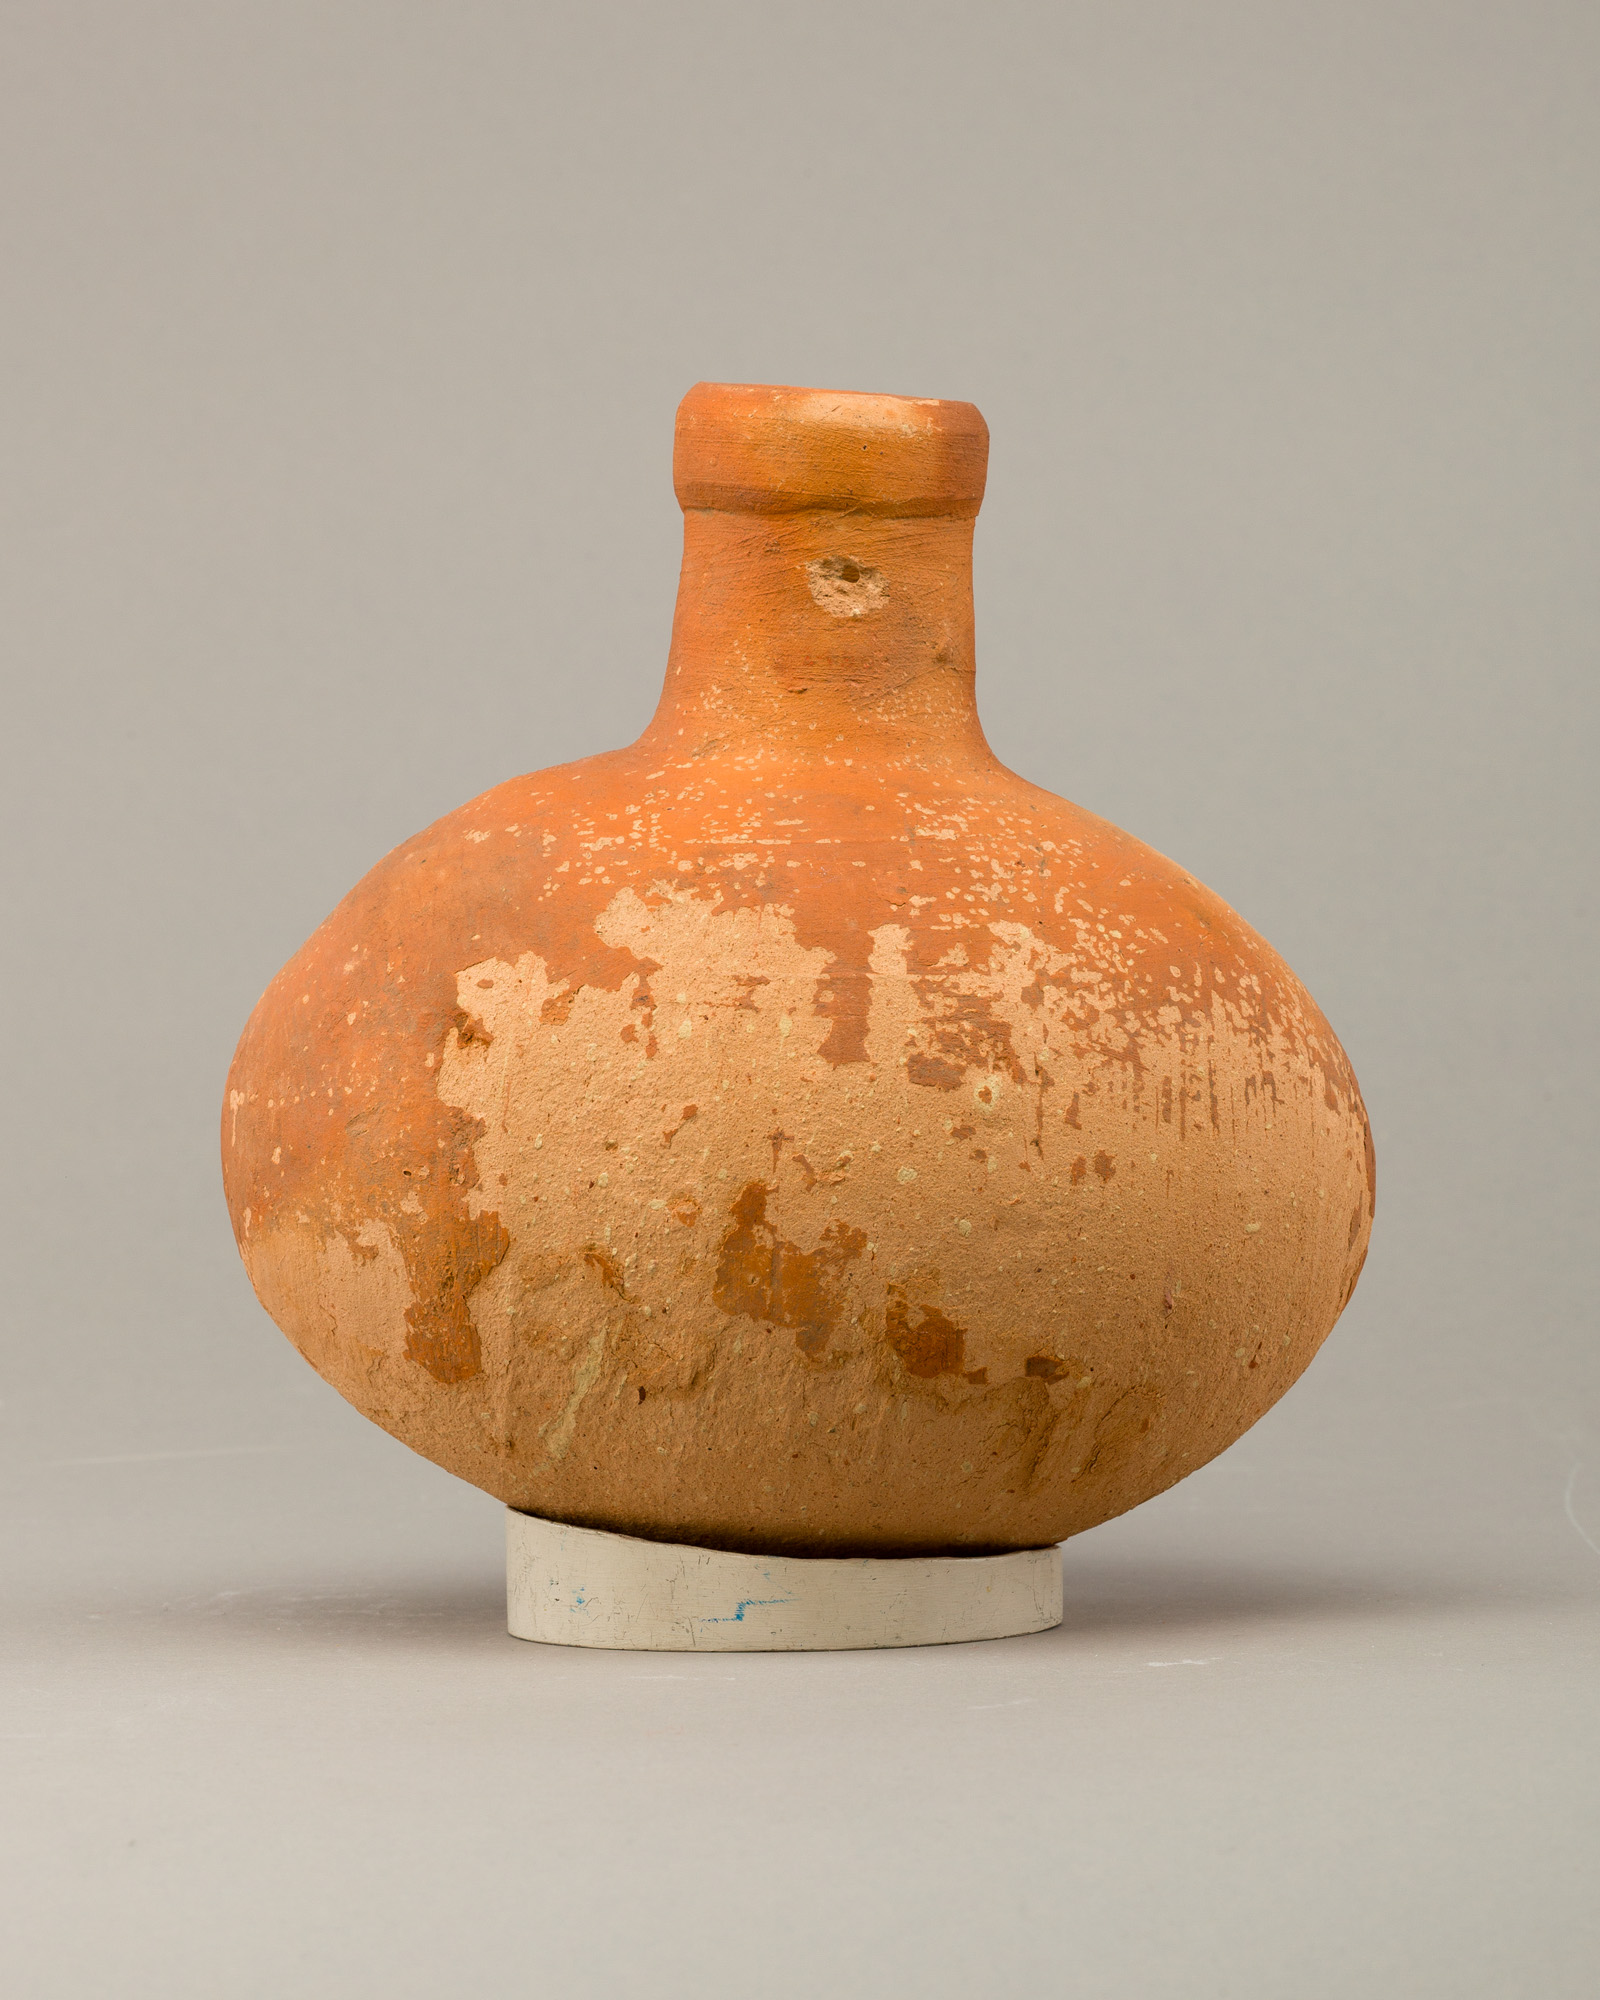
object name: bottle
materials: pottery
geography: egypt